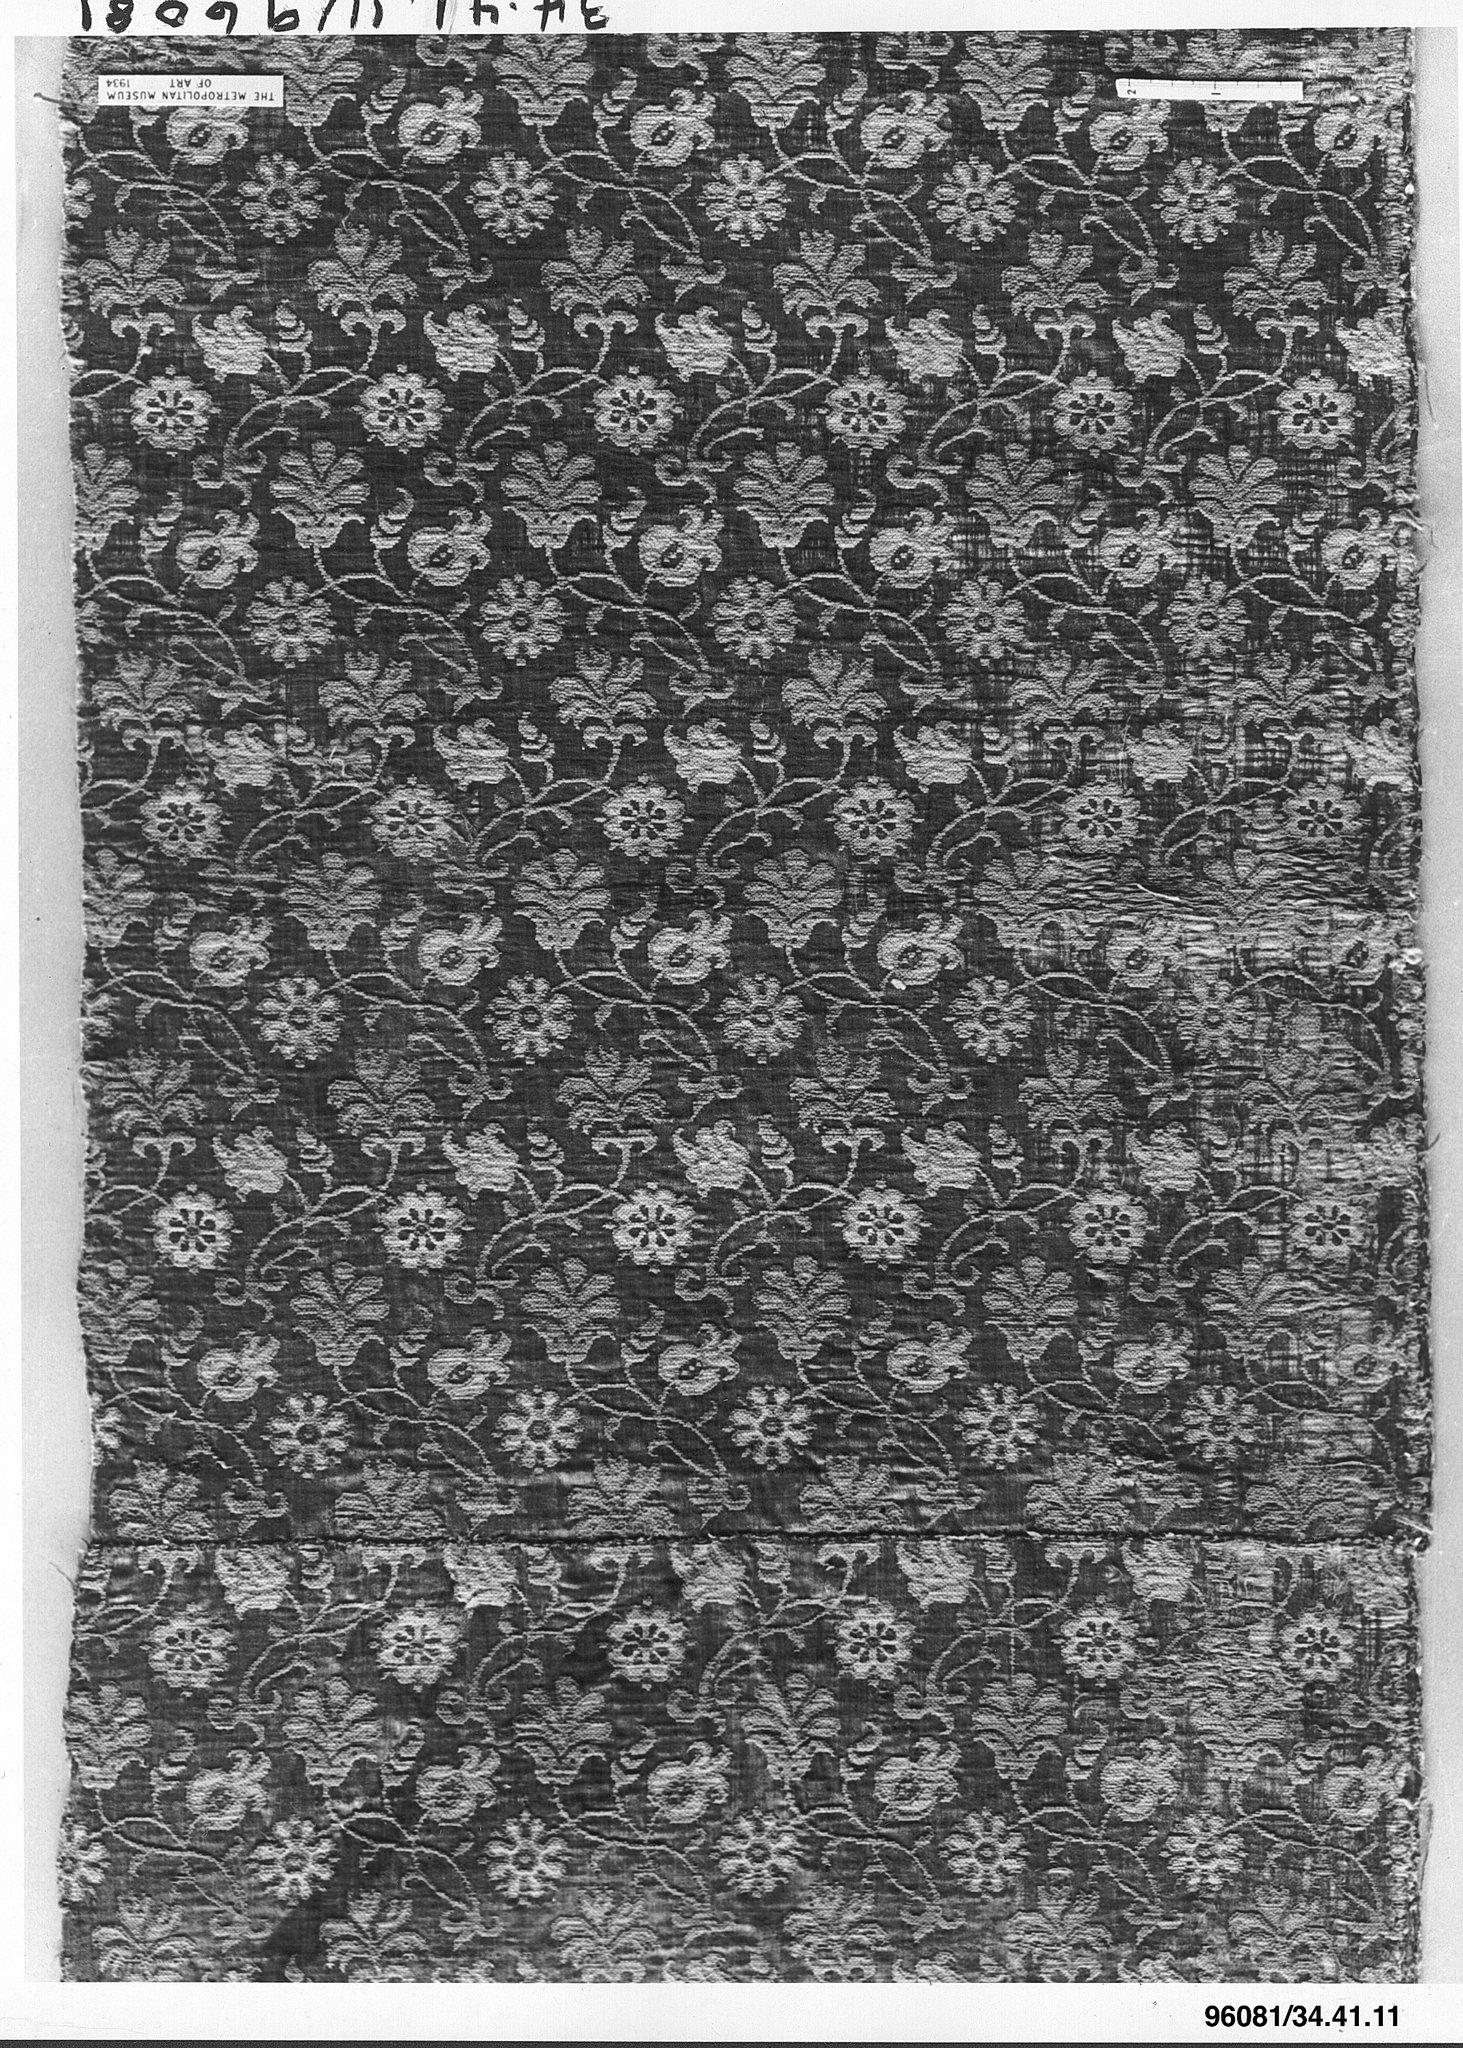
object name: piece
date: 1601-1700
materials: linen, silk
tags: flowers,leaves